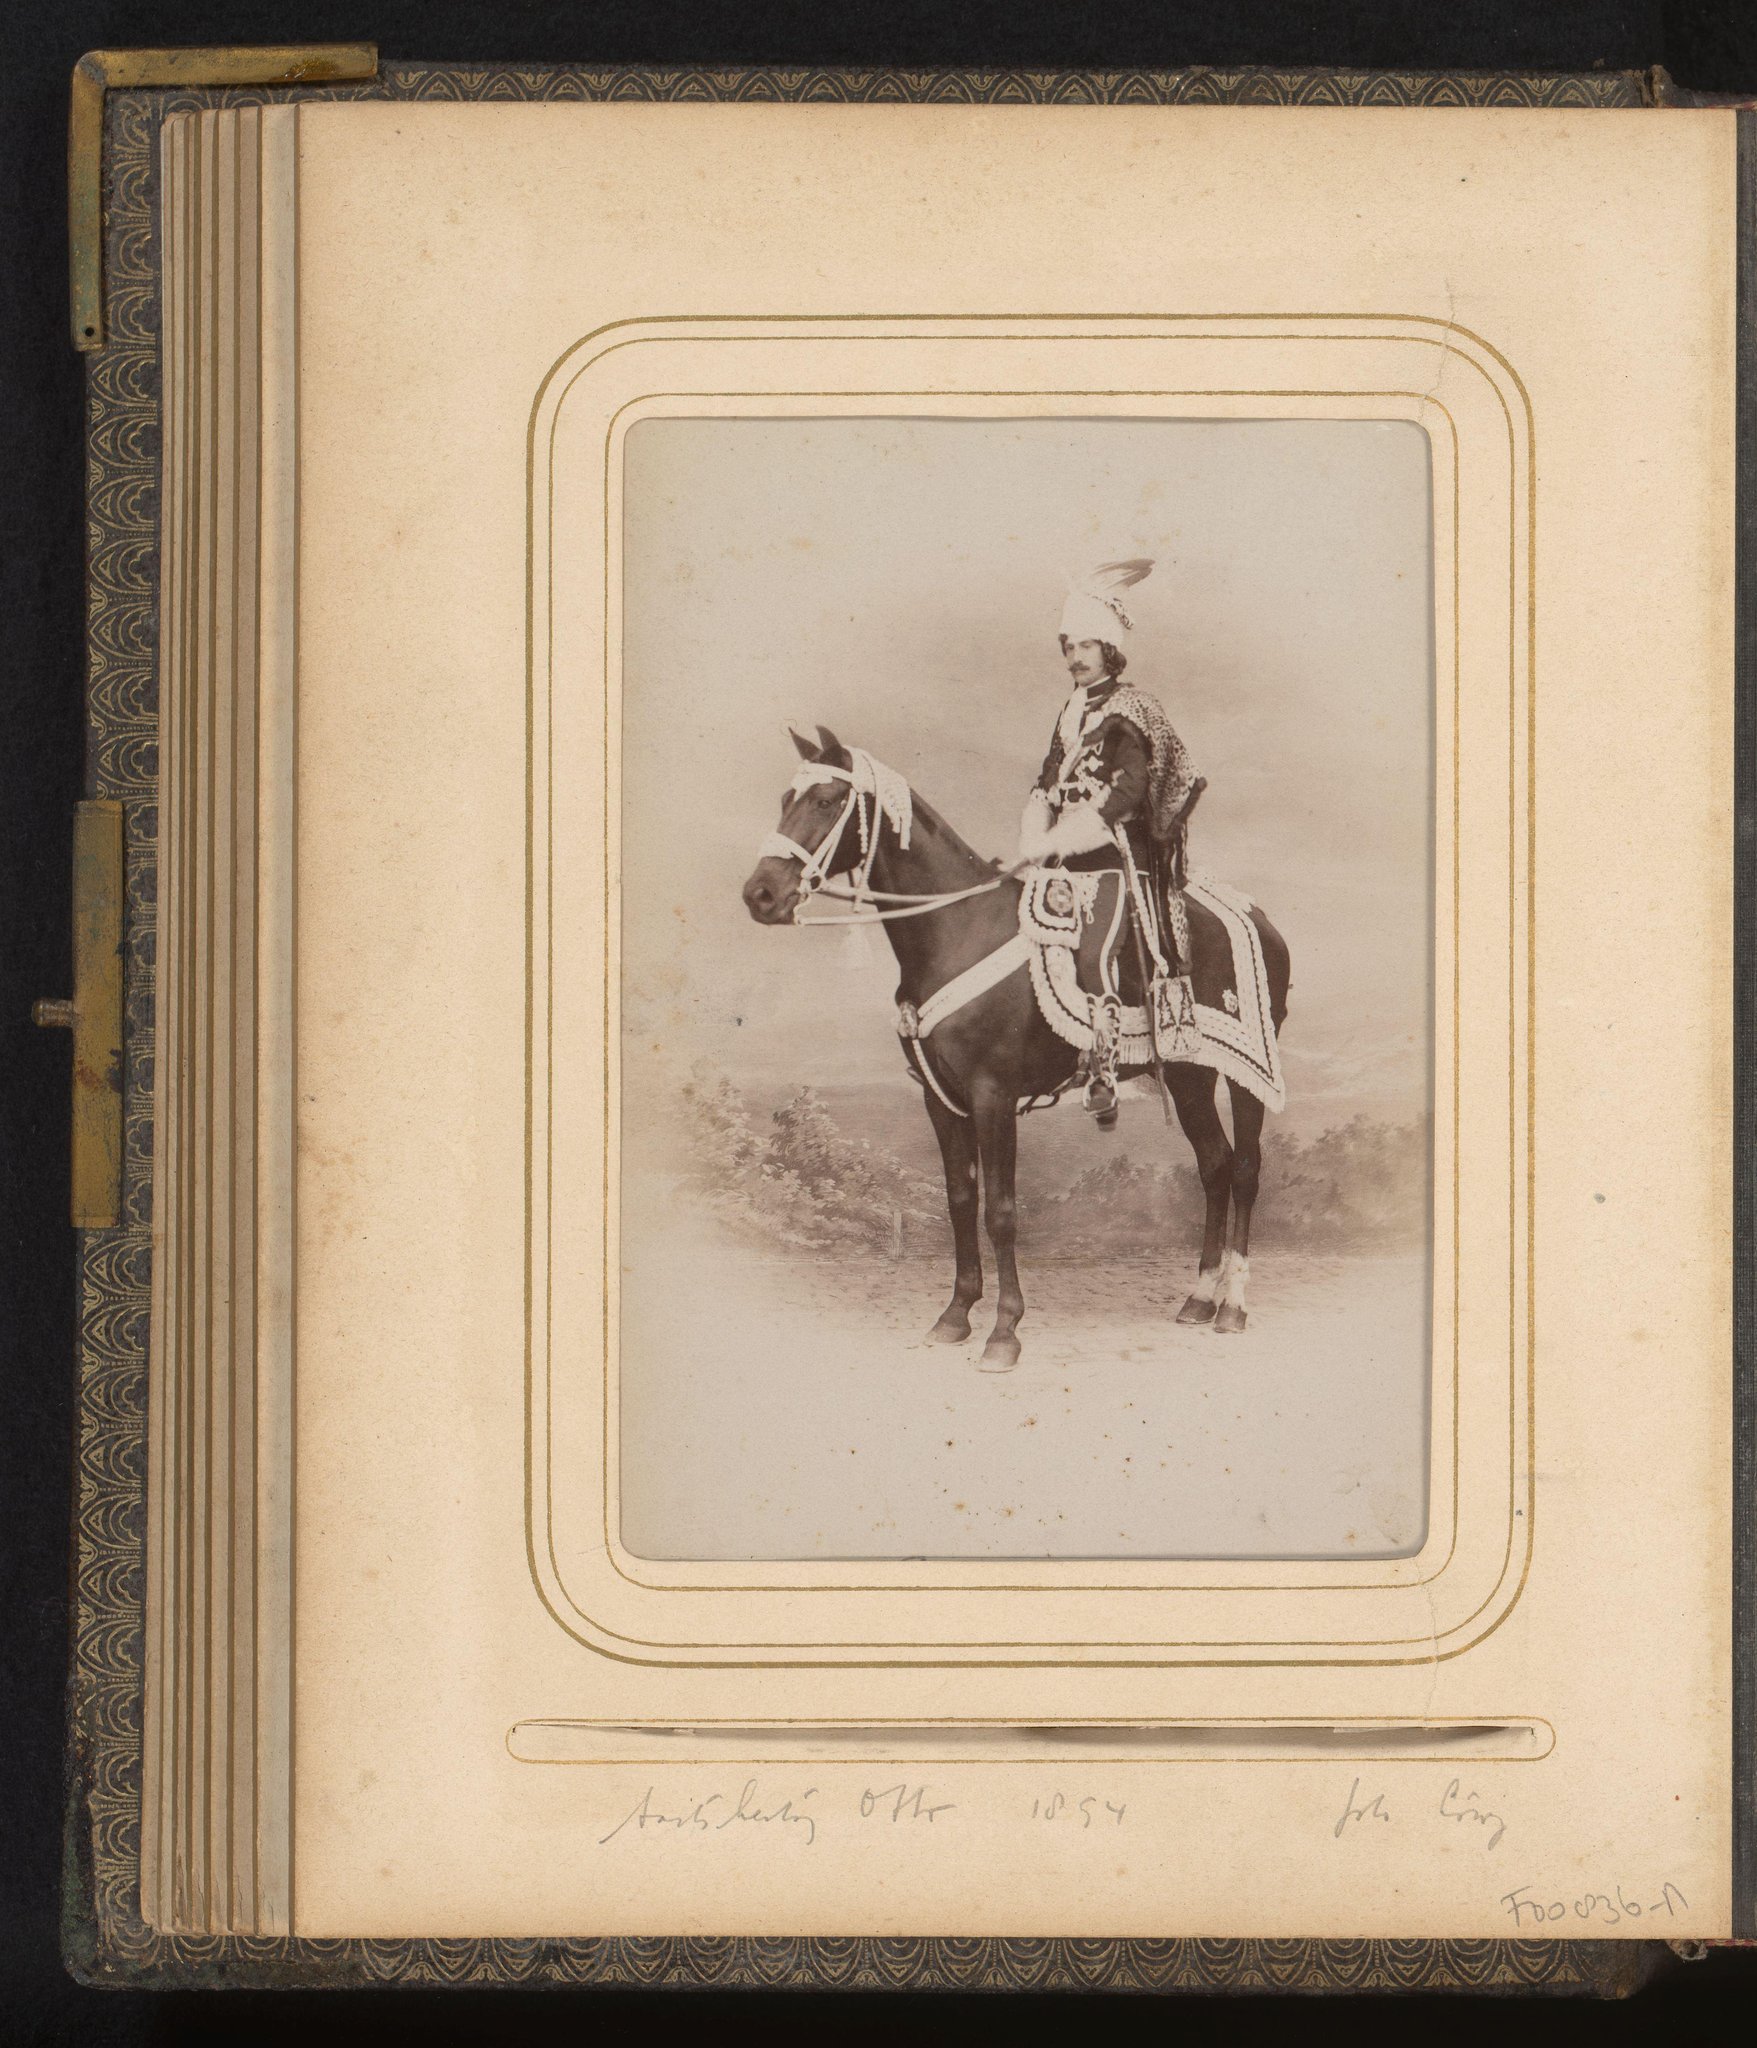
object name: photograph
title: Portret van aartshertog Otto te paard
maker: josef löwy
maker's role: publisher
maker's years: 1835-1902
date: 1894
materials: cardboard, photographic support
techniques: collodion silver print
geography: vienna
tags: vienna, riding a horse, ass, or mule; rider, horseman, historical persons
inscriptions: annotation: ‘Erzh. Otto’, annotation: ‘Aartshertog Otto 1894/ foto Löwy’